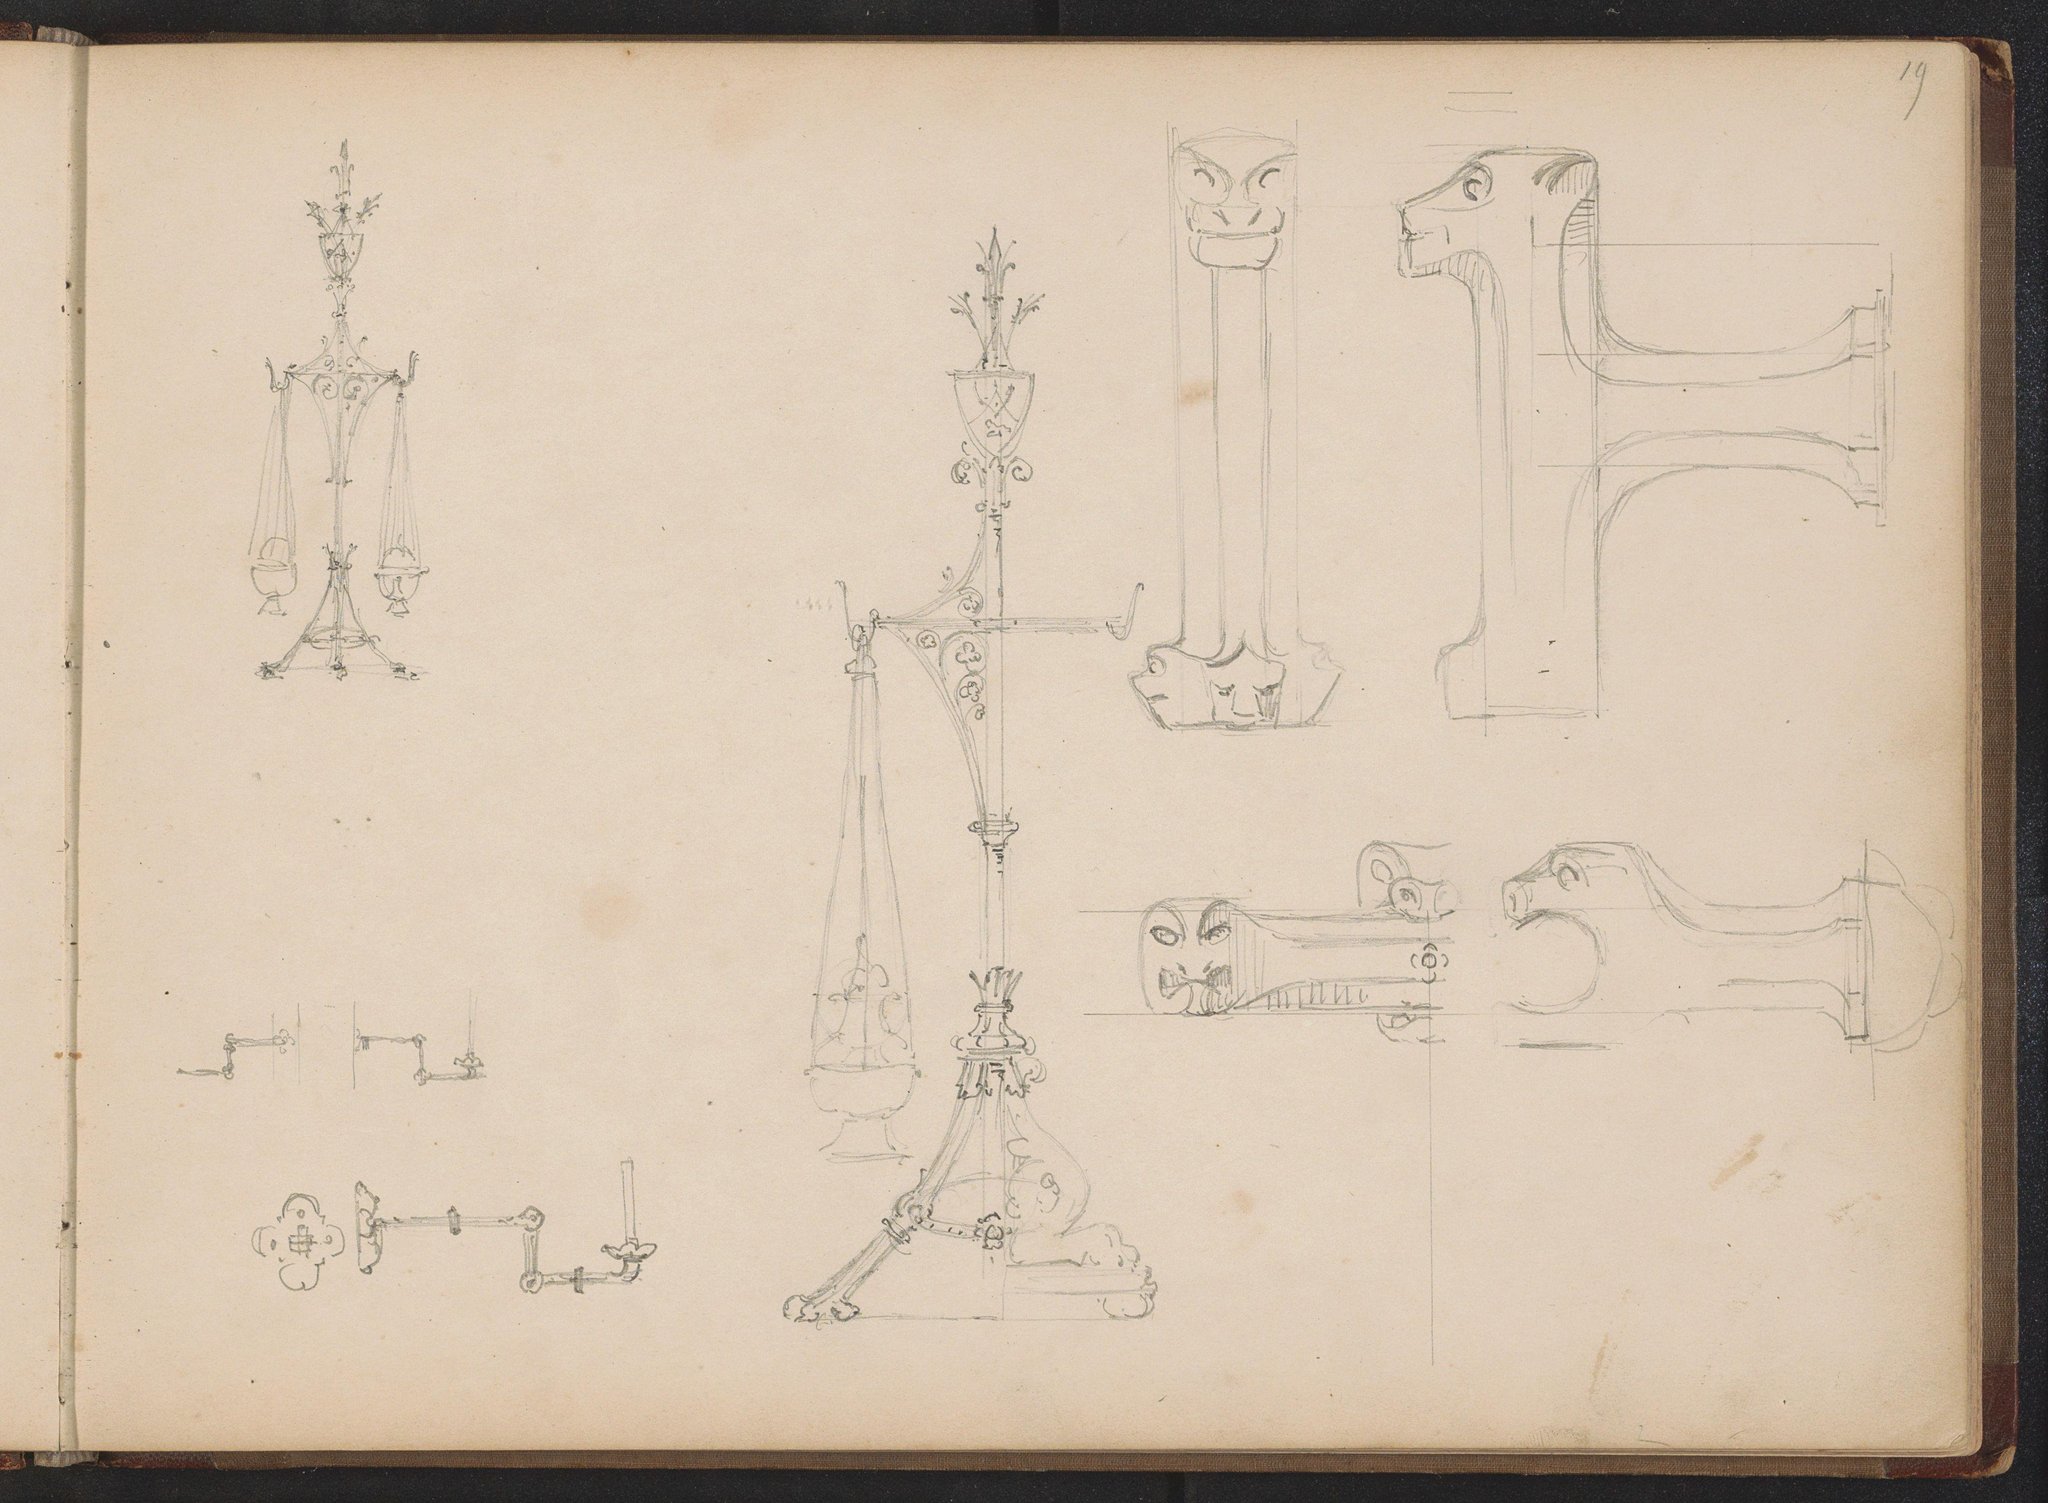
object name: sketchbook leaf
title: Wierookvaten en deurknoppen met dierenkoppen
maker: pierre joseph hubert cuypers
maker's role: draughtsman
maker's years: 1827-1921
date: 1857-1859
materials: paper, pencil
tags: ornament derived from animal forms, door-handle, doorknob, censer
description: Blad 19 recto uit een schetsboek met 77 bladen.